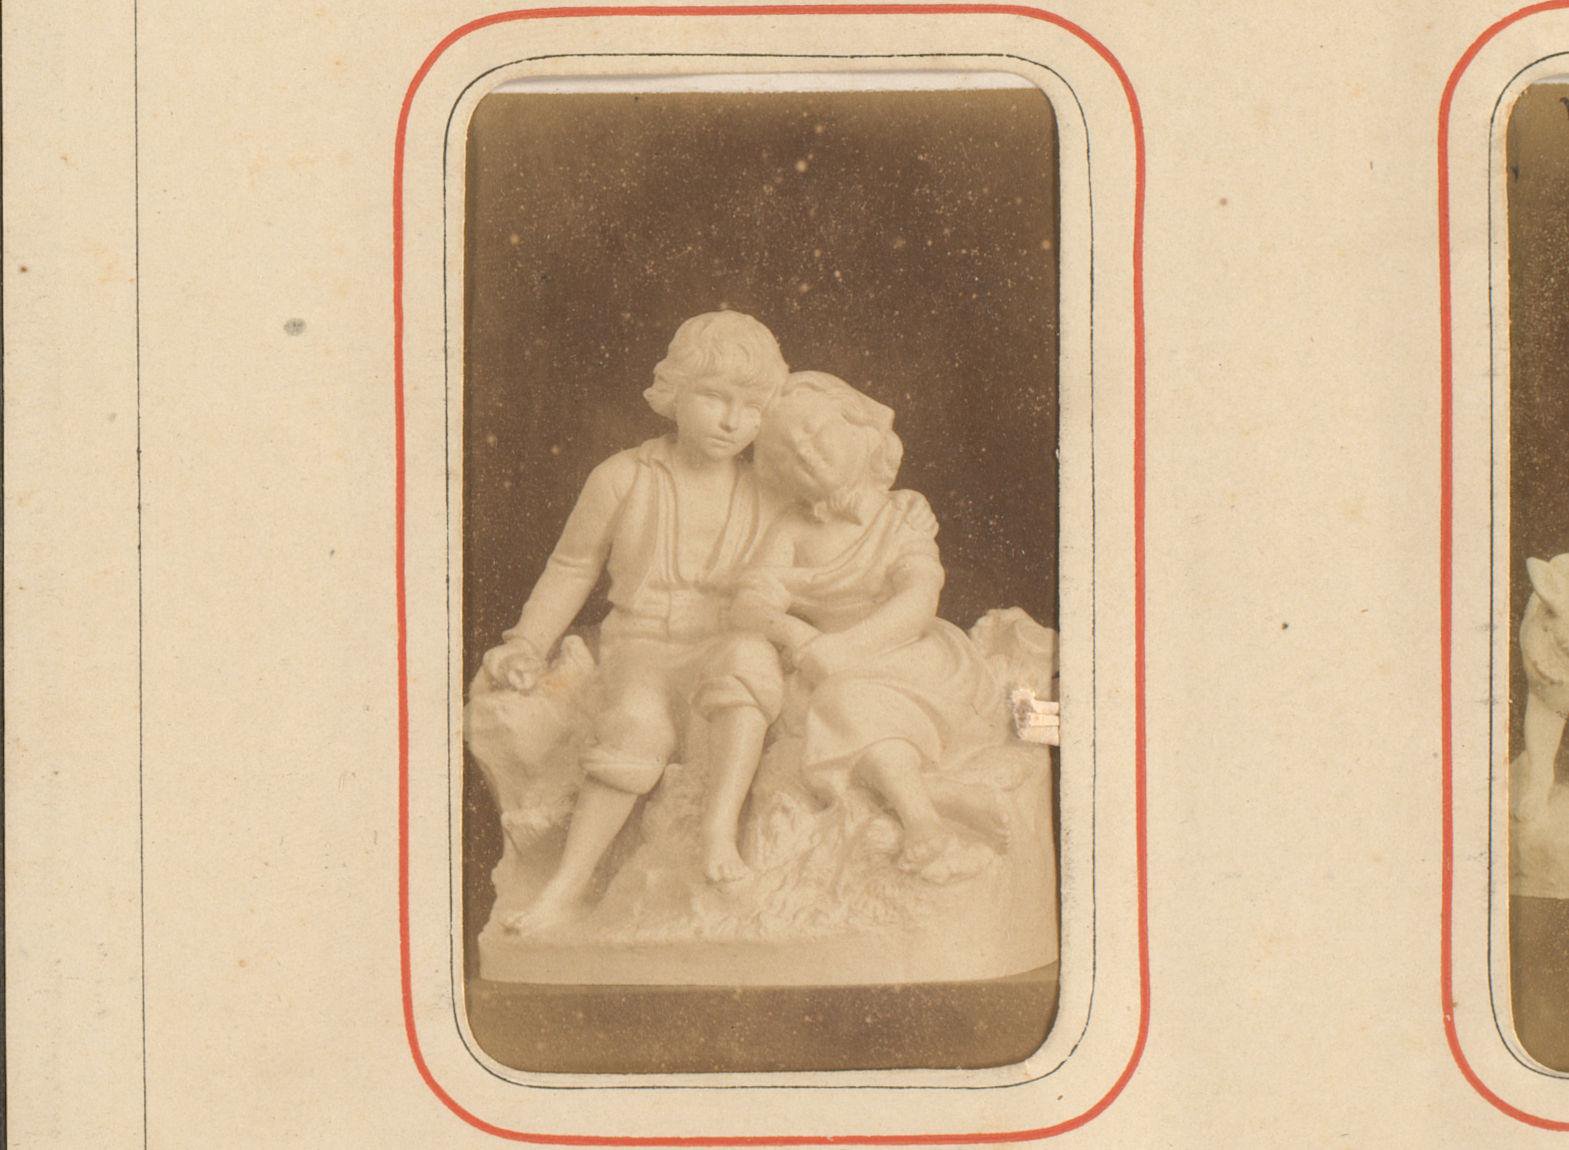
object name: reproduction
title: Fotoreproductie van een gipsen kopie van een sculptuur van Hans en Grietje door Robert Cauer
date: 1870-1890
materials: cardboard, paper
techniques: albumen print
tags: sculpture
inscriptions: number: ‘462’